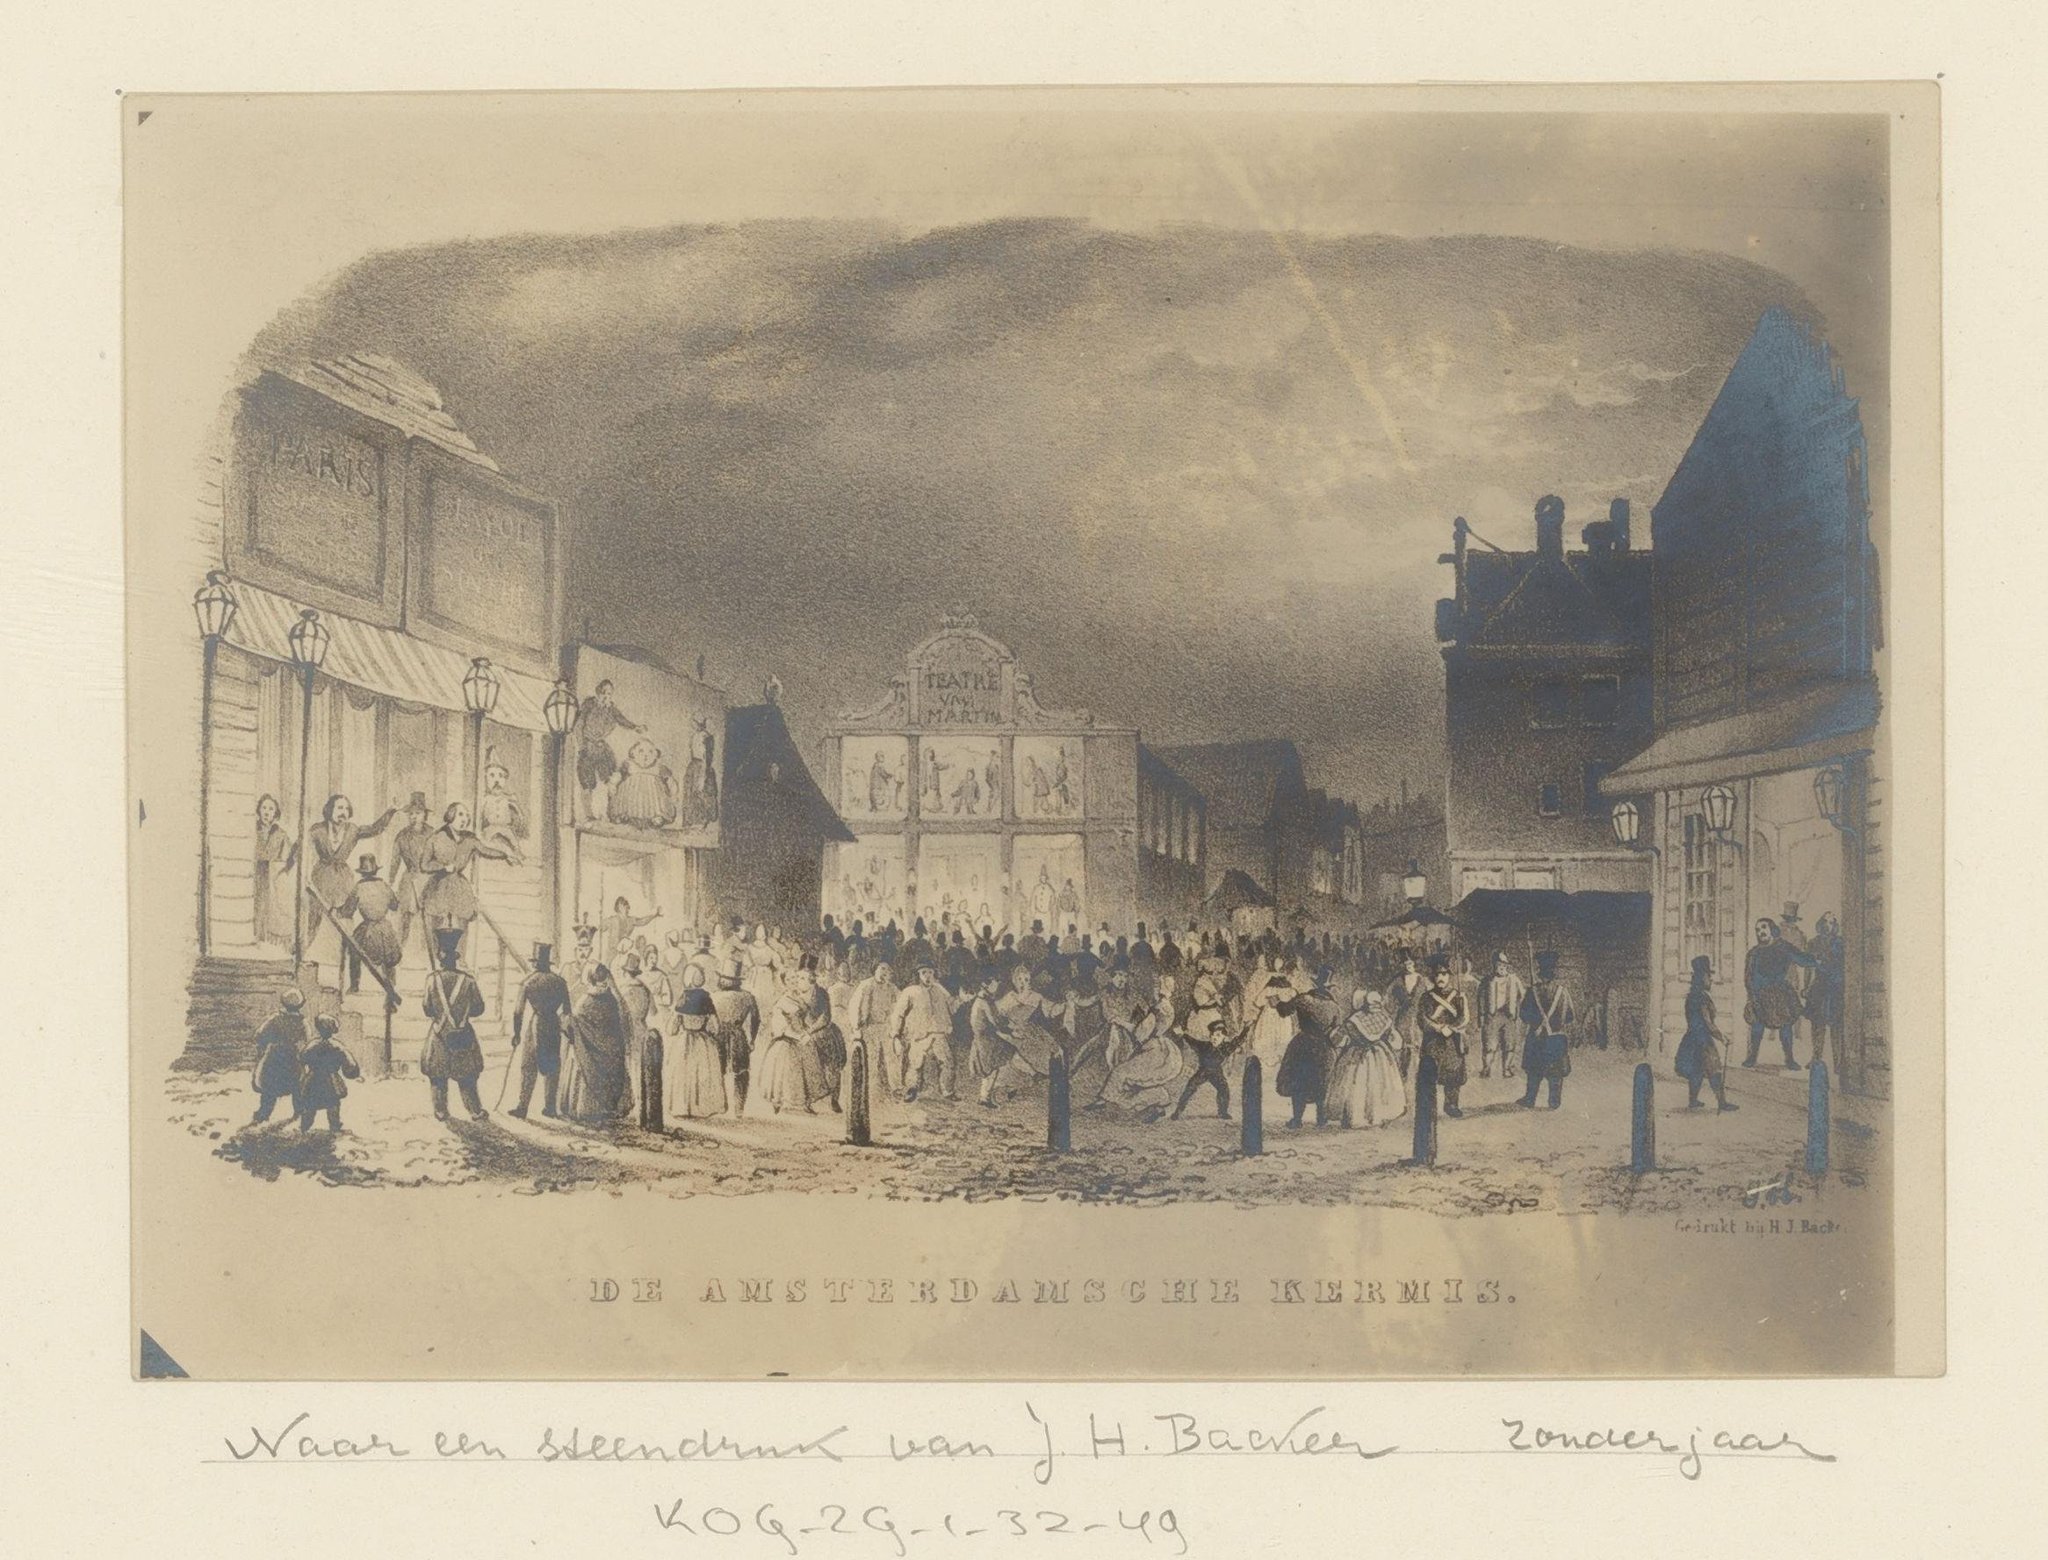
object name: photograph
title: Fotoreproductie van een prent van de Amsterdamse kermis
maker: Anonymous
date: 1875-1925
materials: photographic support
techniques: gelatin silver print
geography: netherlands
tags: pleasure fair and circus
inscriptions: collector's mark: Lugt 1641, collector's mark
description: Foto van een prent getiteld 'De Amsterdamsche Kermis'. Kermis op de Botermarkt. Prent in de collectie van het Stadsarchief te Amsterdam. Onderwerpsrubrieken binnen de Atlas Zeden en Gewoonten: Volksfeesten; Kermis.